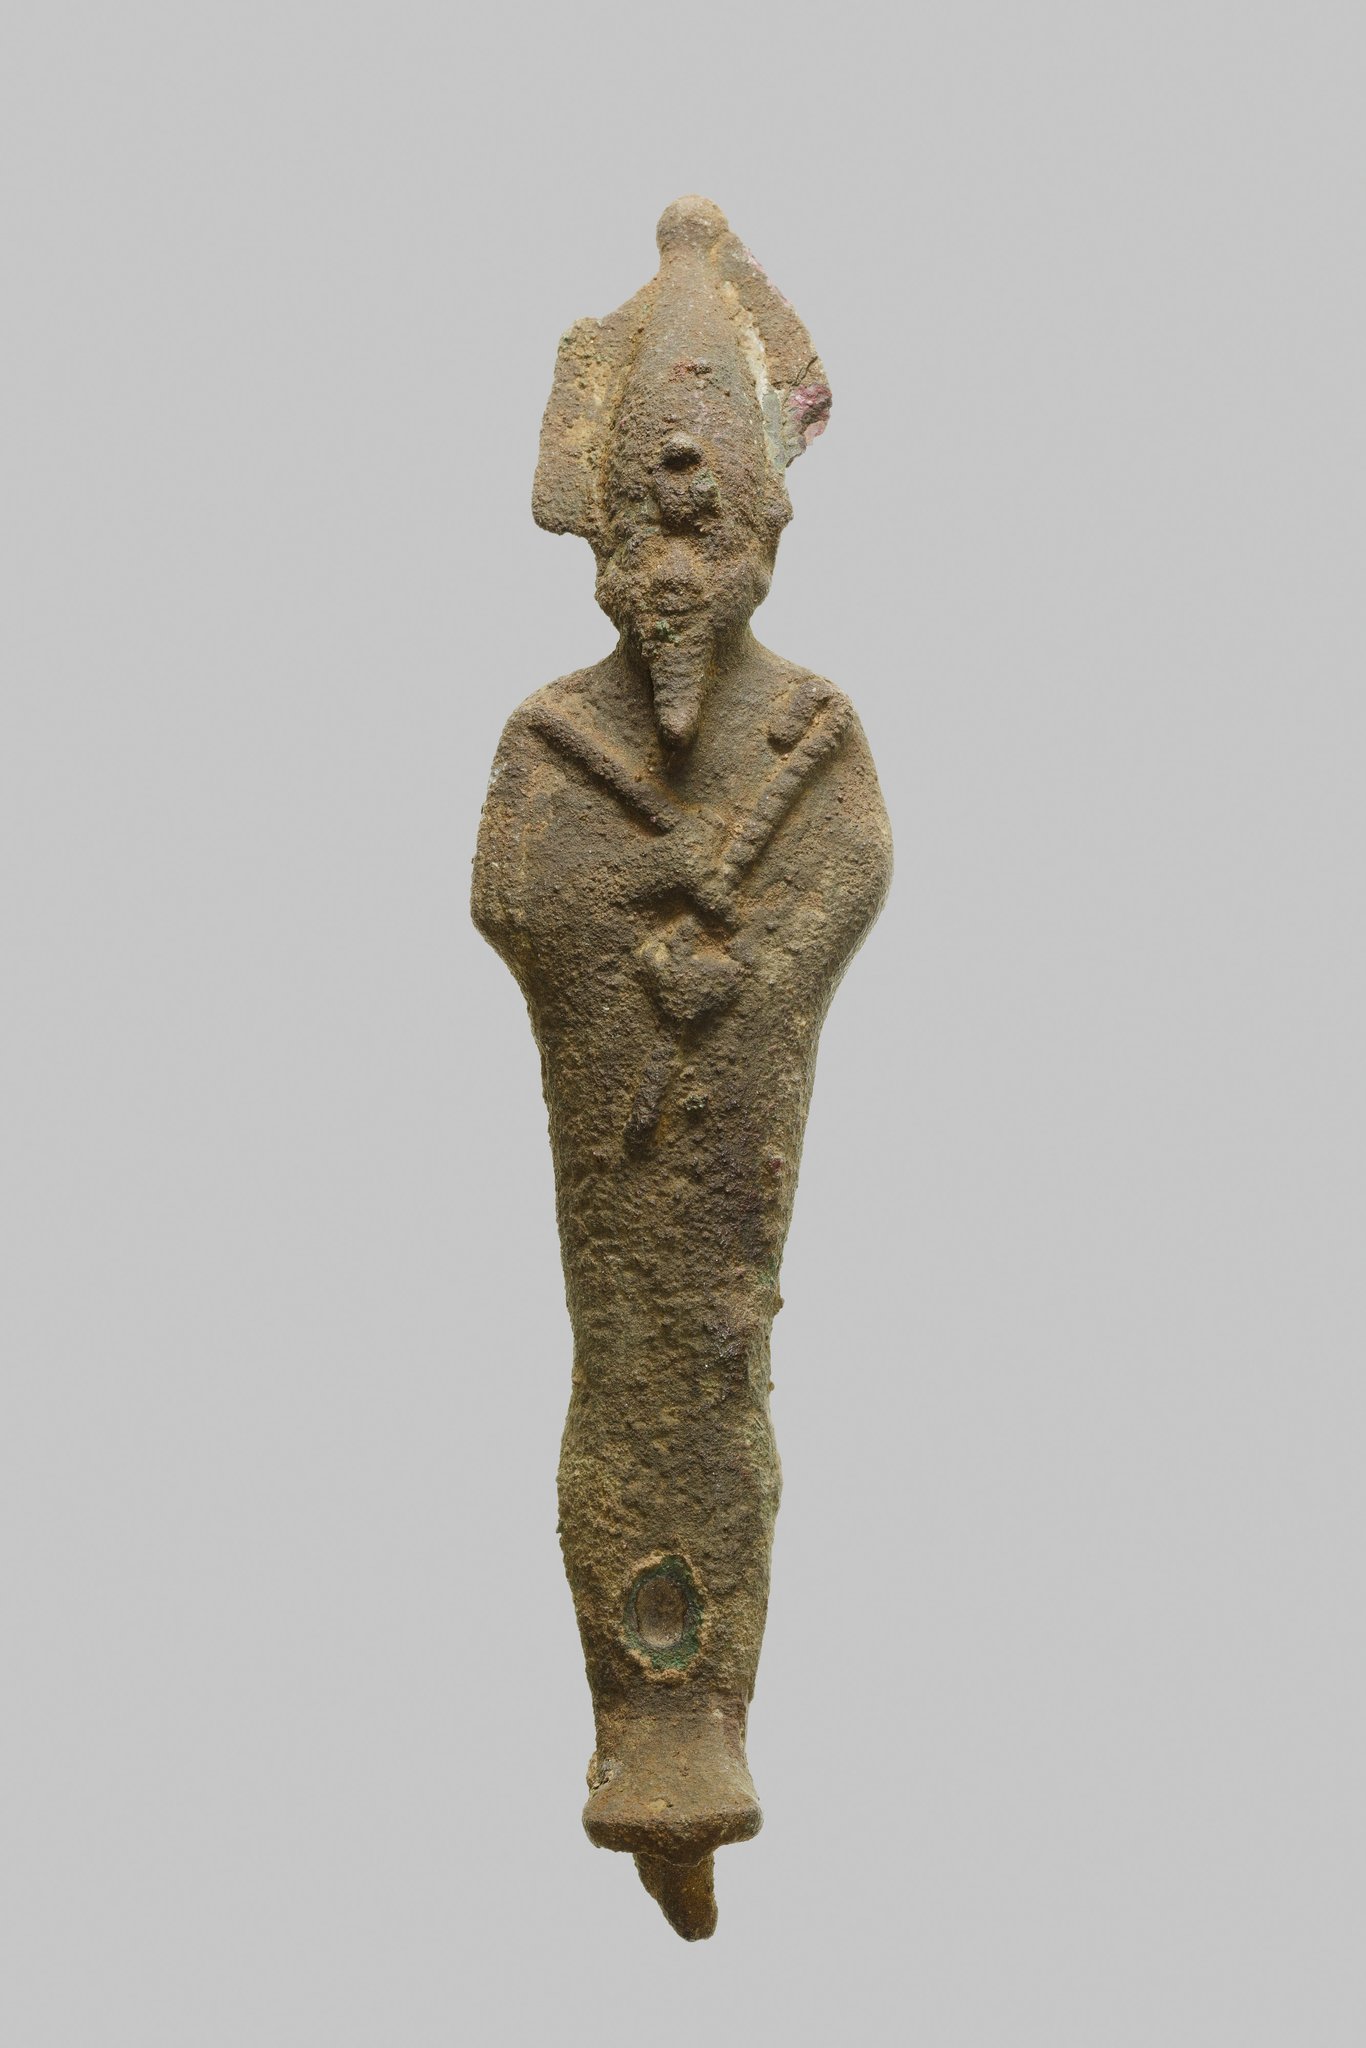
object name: statuette, osiris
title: Statuette of Osiris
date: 712-30 BCE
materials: bronze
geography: egypt